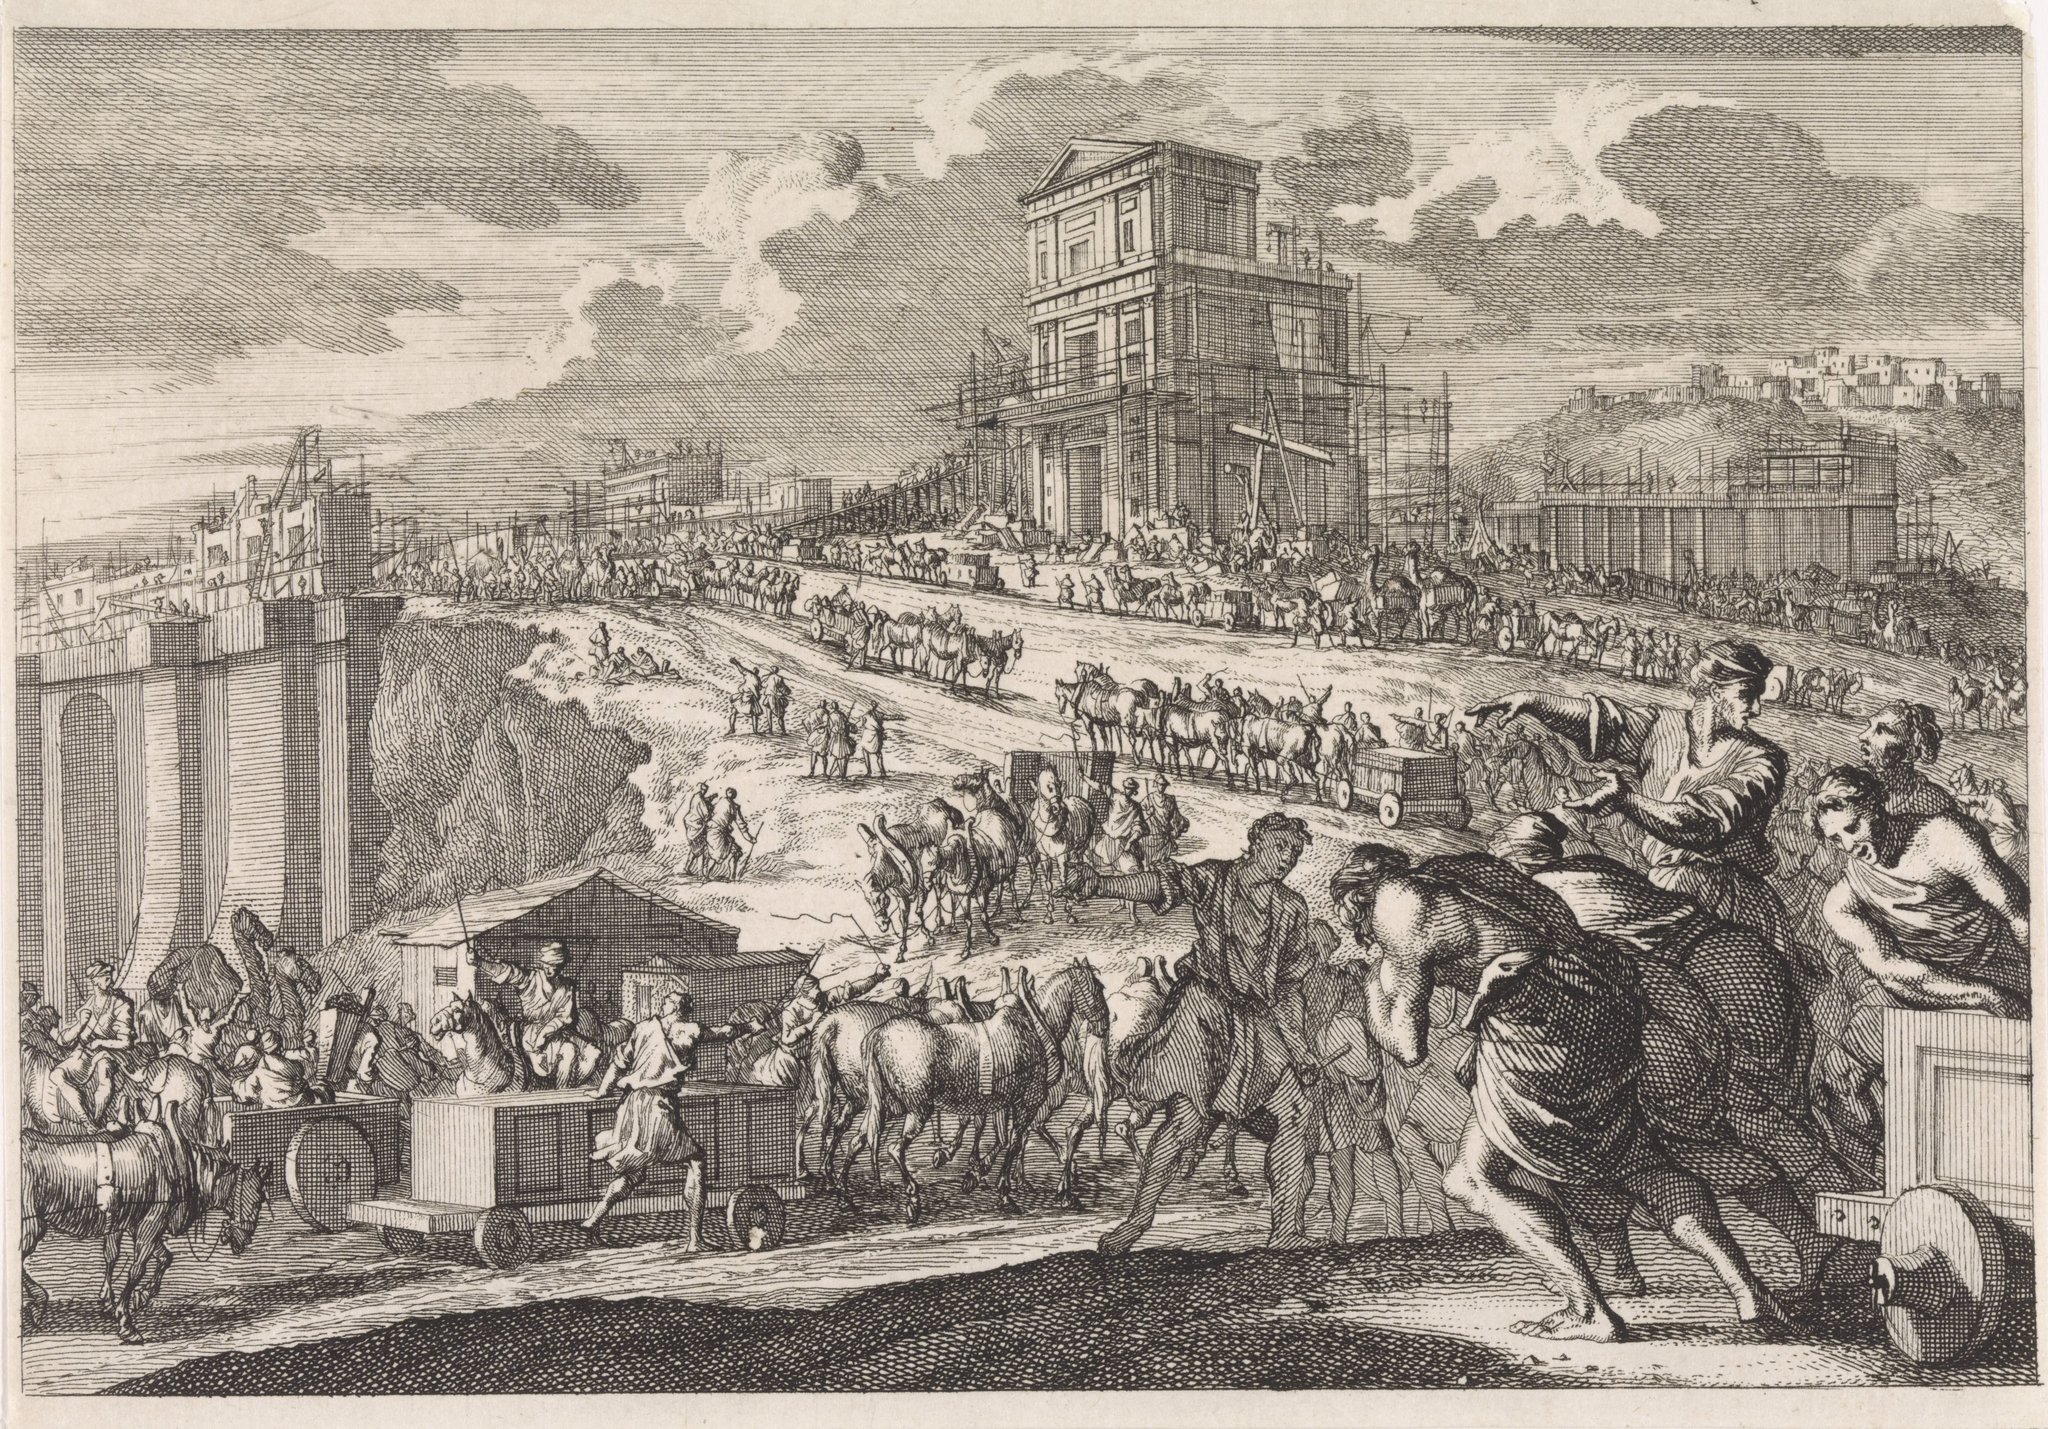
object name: print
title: Bouw van de tempel van Salomo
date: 1700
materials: paper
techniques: etching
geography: amsterdam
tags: the construction of the temple of solomon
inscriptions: collector's mark: Lugt 2228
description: Proefdruk voor een boekillustratie voor David Martin. Historie des Ouden en Nieuwen Testaments, verrykt met meer dan vierhonderd printverbeeldingen. Amsterdam: Pieter Mortier, 1700.